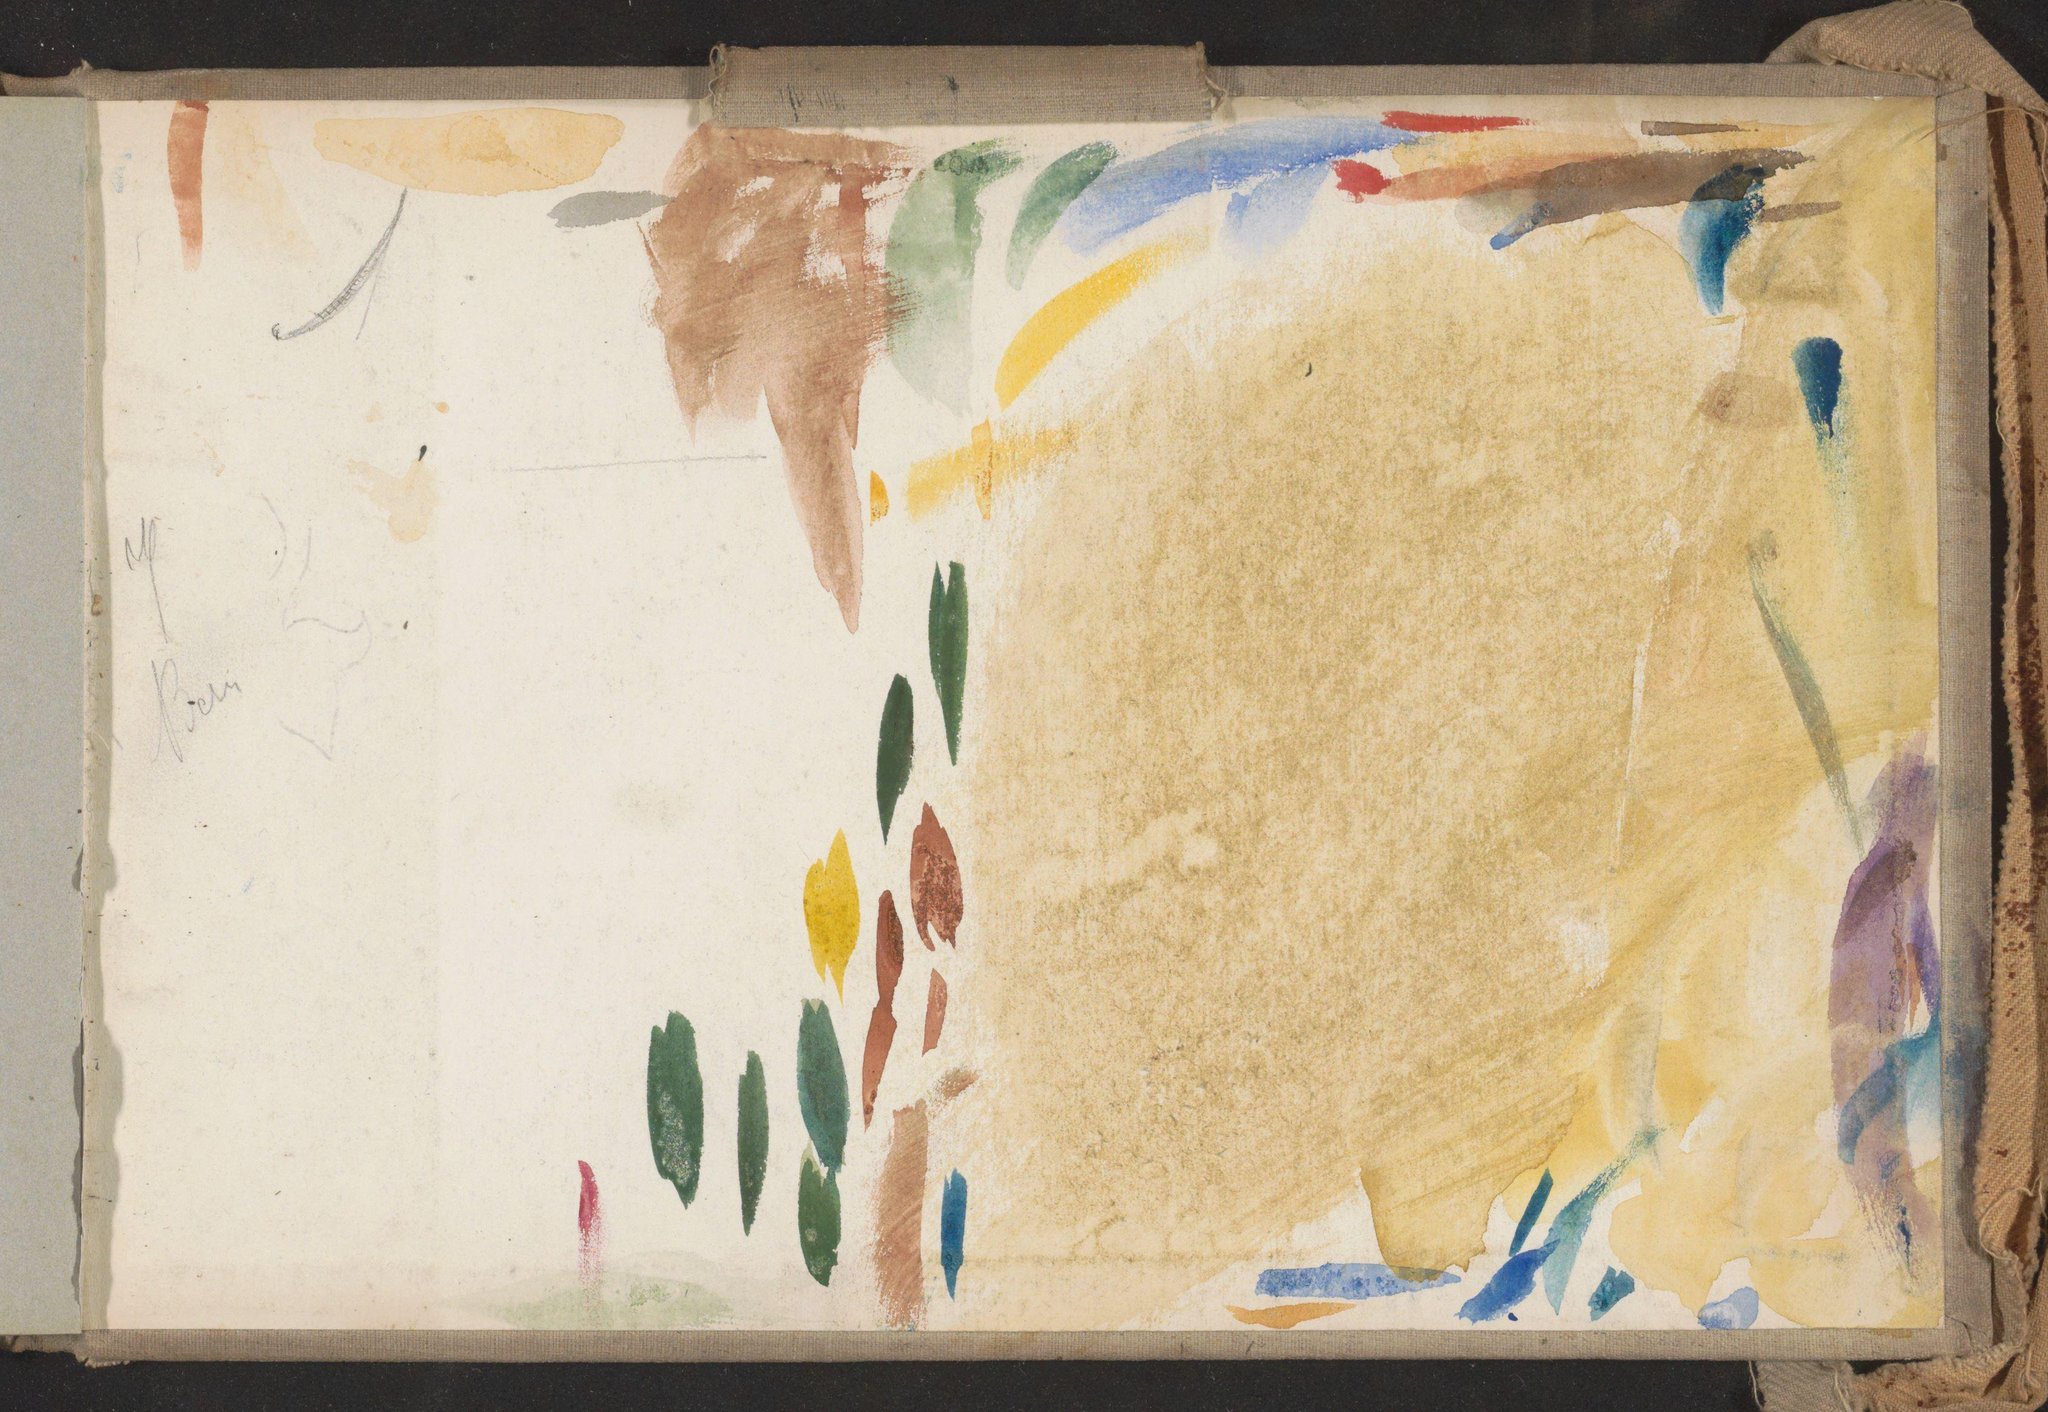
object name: sketchbook leaf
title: Studies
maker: johanna van de kamer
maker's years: 1873-1922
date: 1890-1922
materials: paper, watercolor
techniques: brush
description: Achterste schutblad uit een schetsboek met 49 bladen.